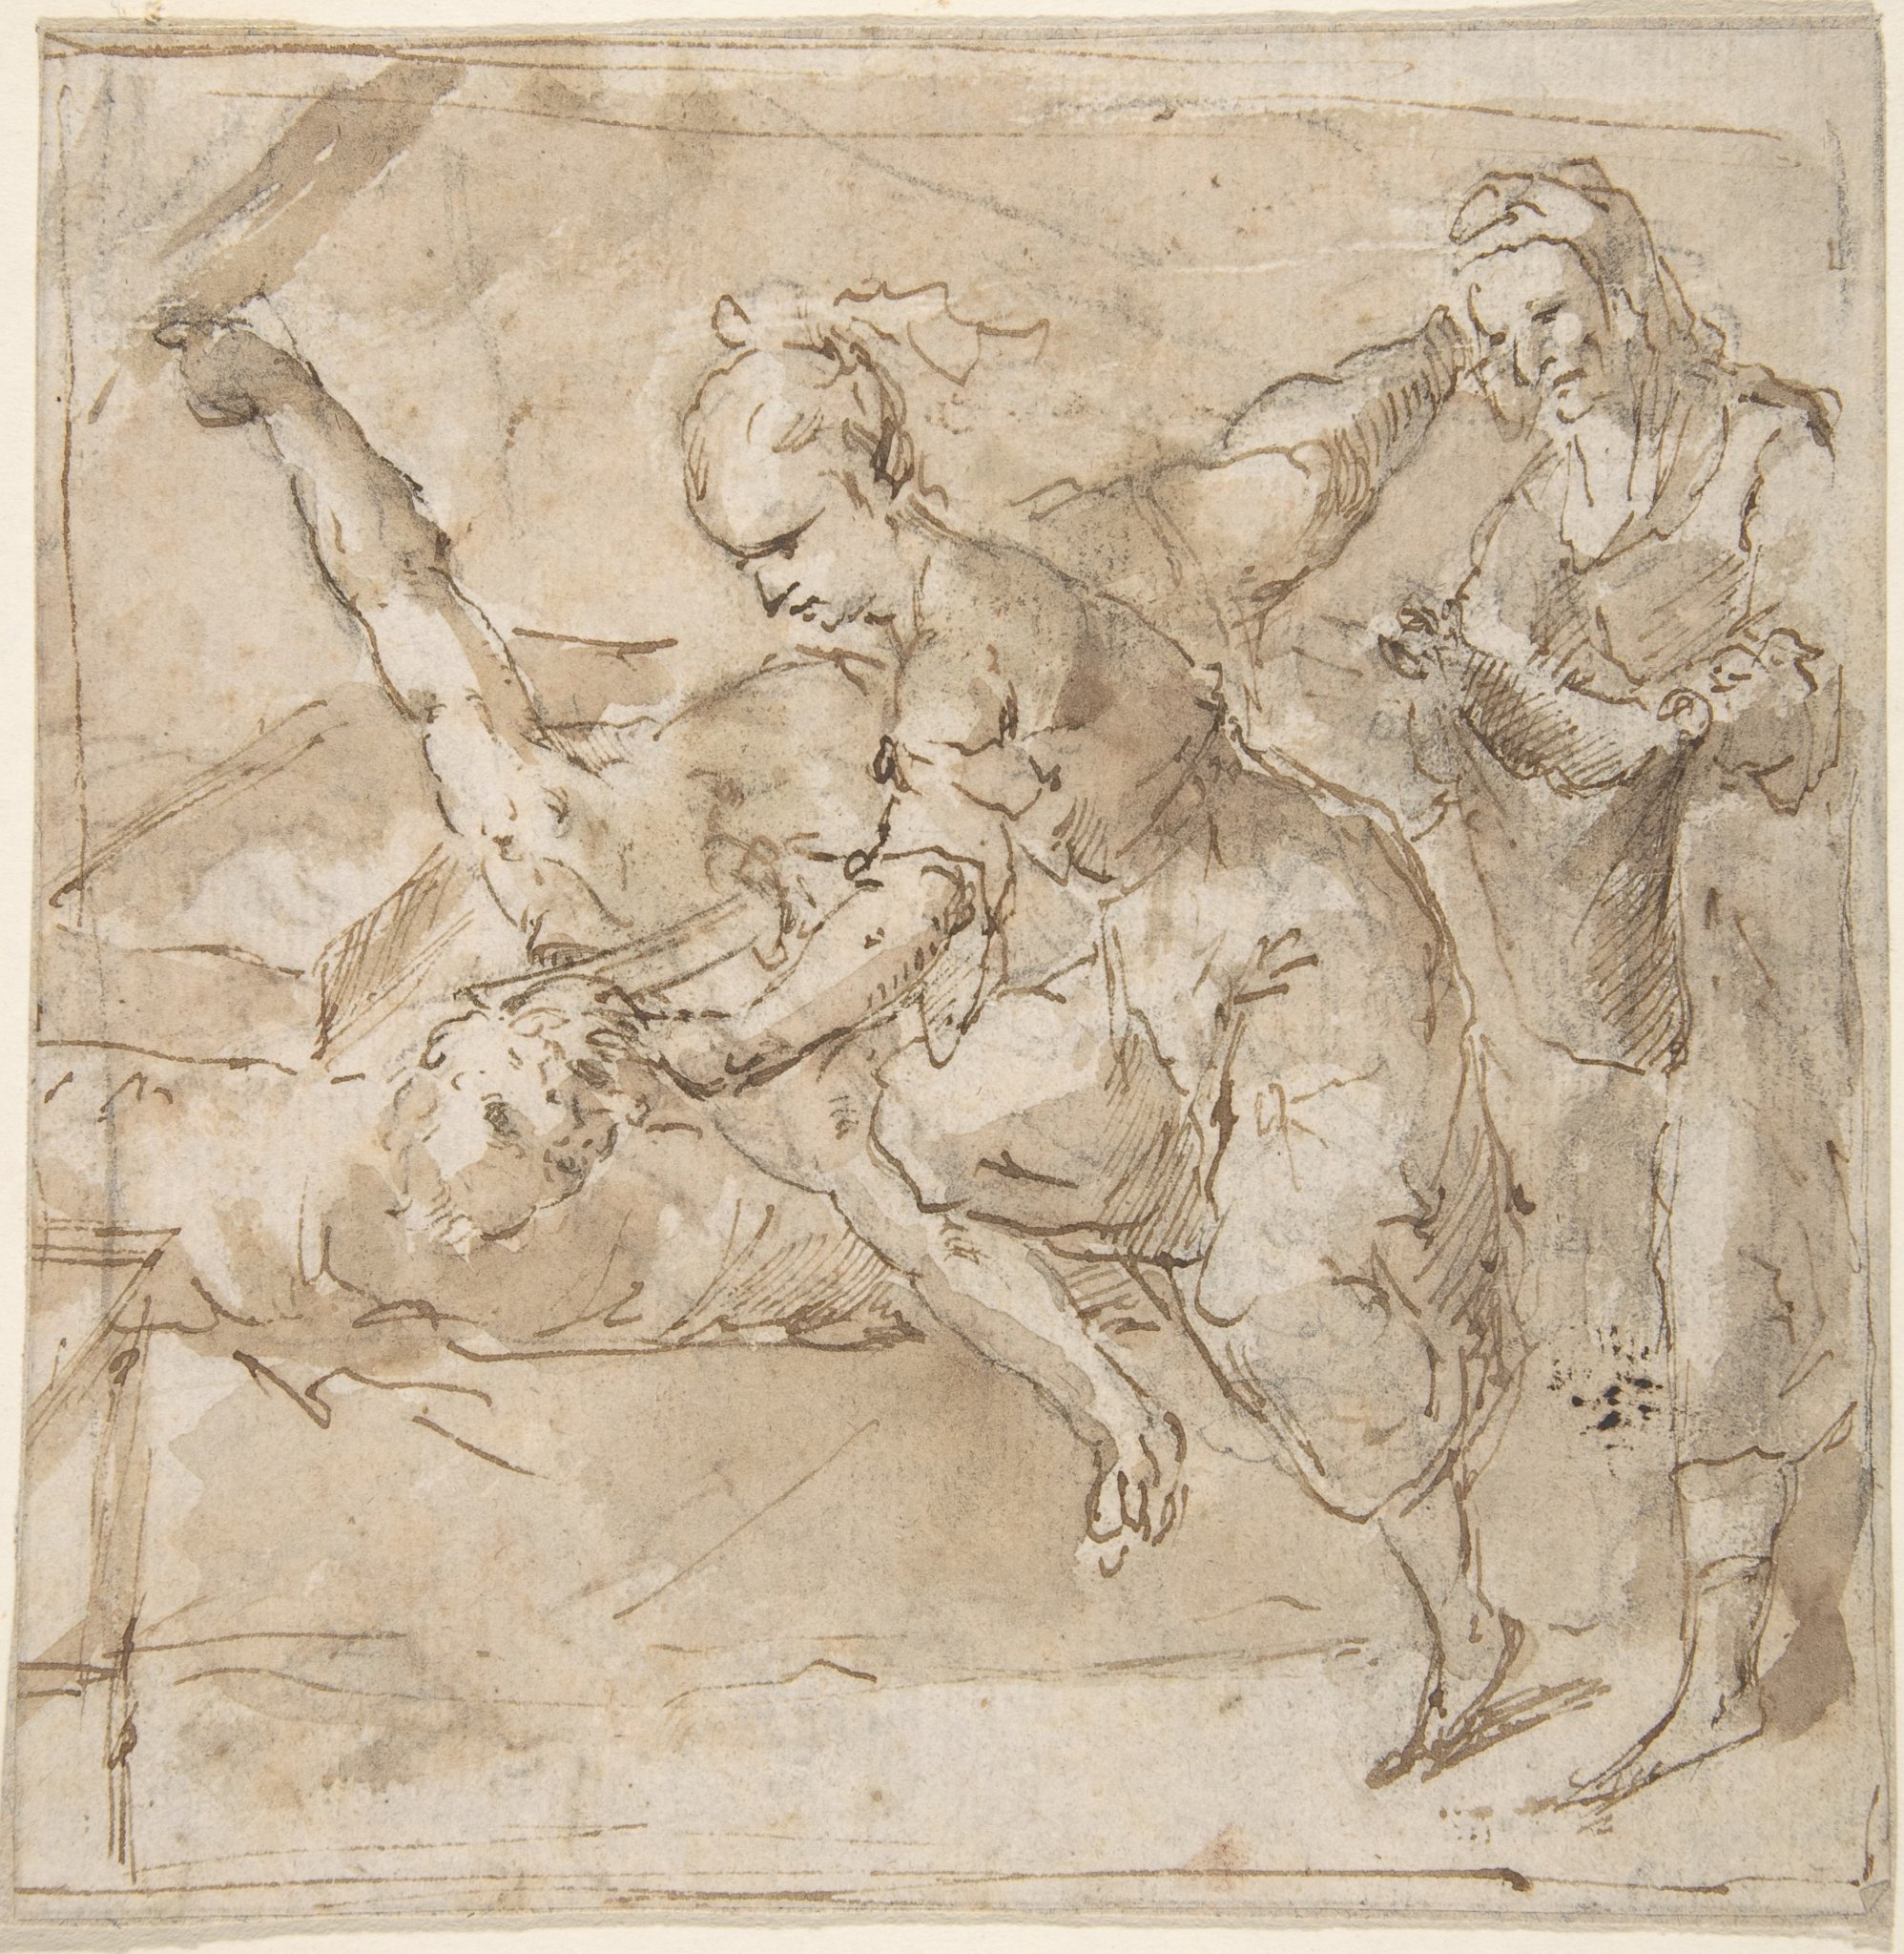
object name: drawing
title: Judith Slaying Holofernes, with Old Woman Servant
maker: anonymous, spanish, school of seville, 17th century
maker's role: artist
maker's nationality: spanish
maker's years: 1600-1700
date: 1601-1700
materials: chalk, ink, paper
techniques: brush, pen, drawing, wash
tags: women,holofernes,judith